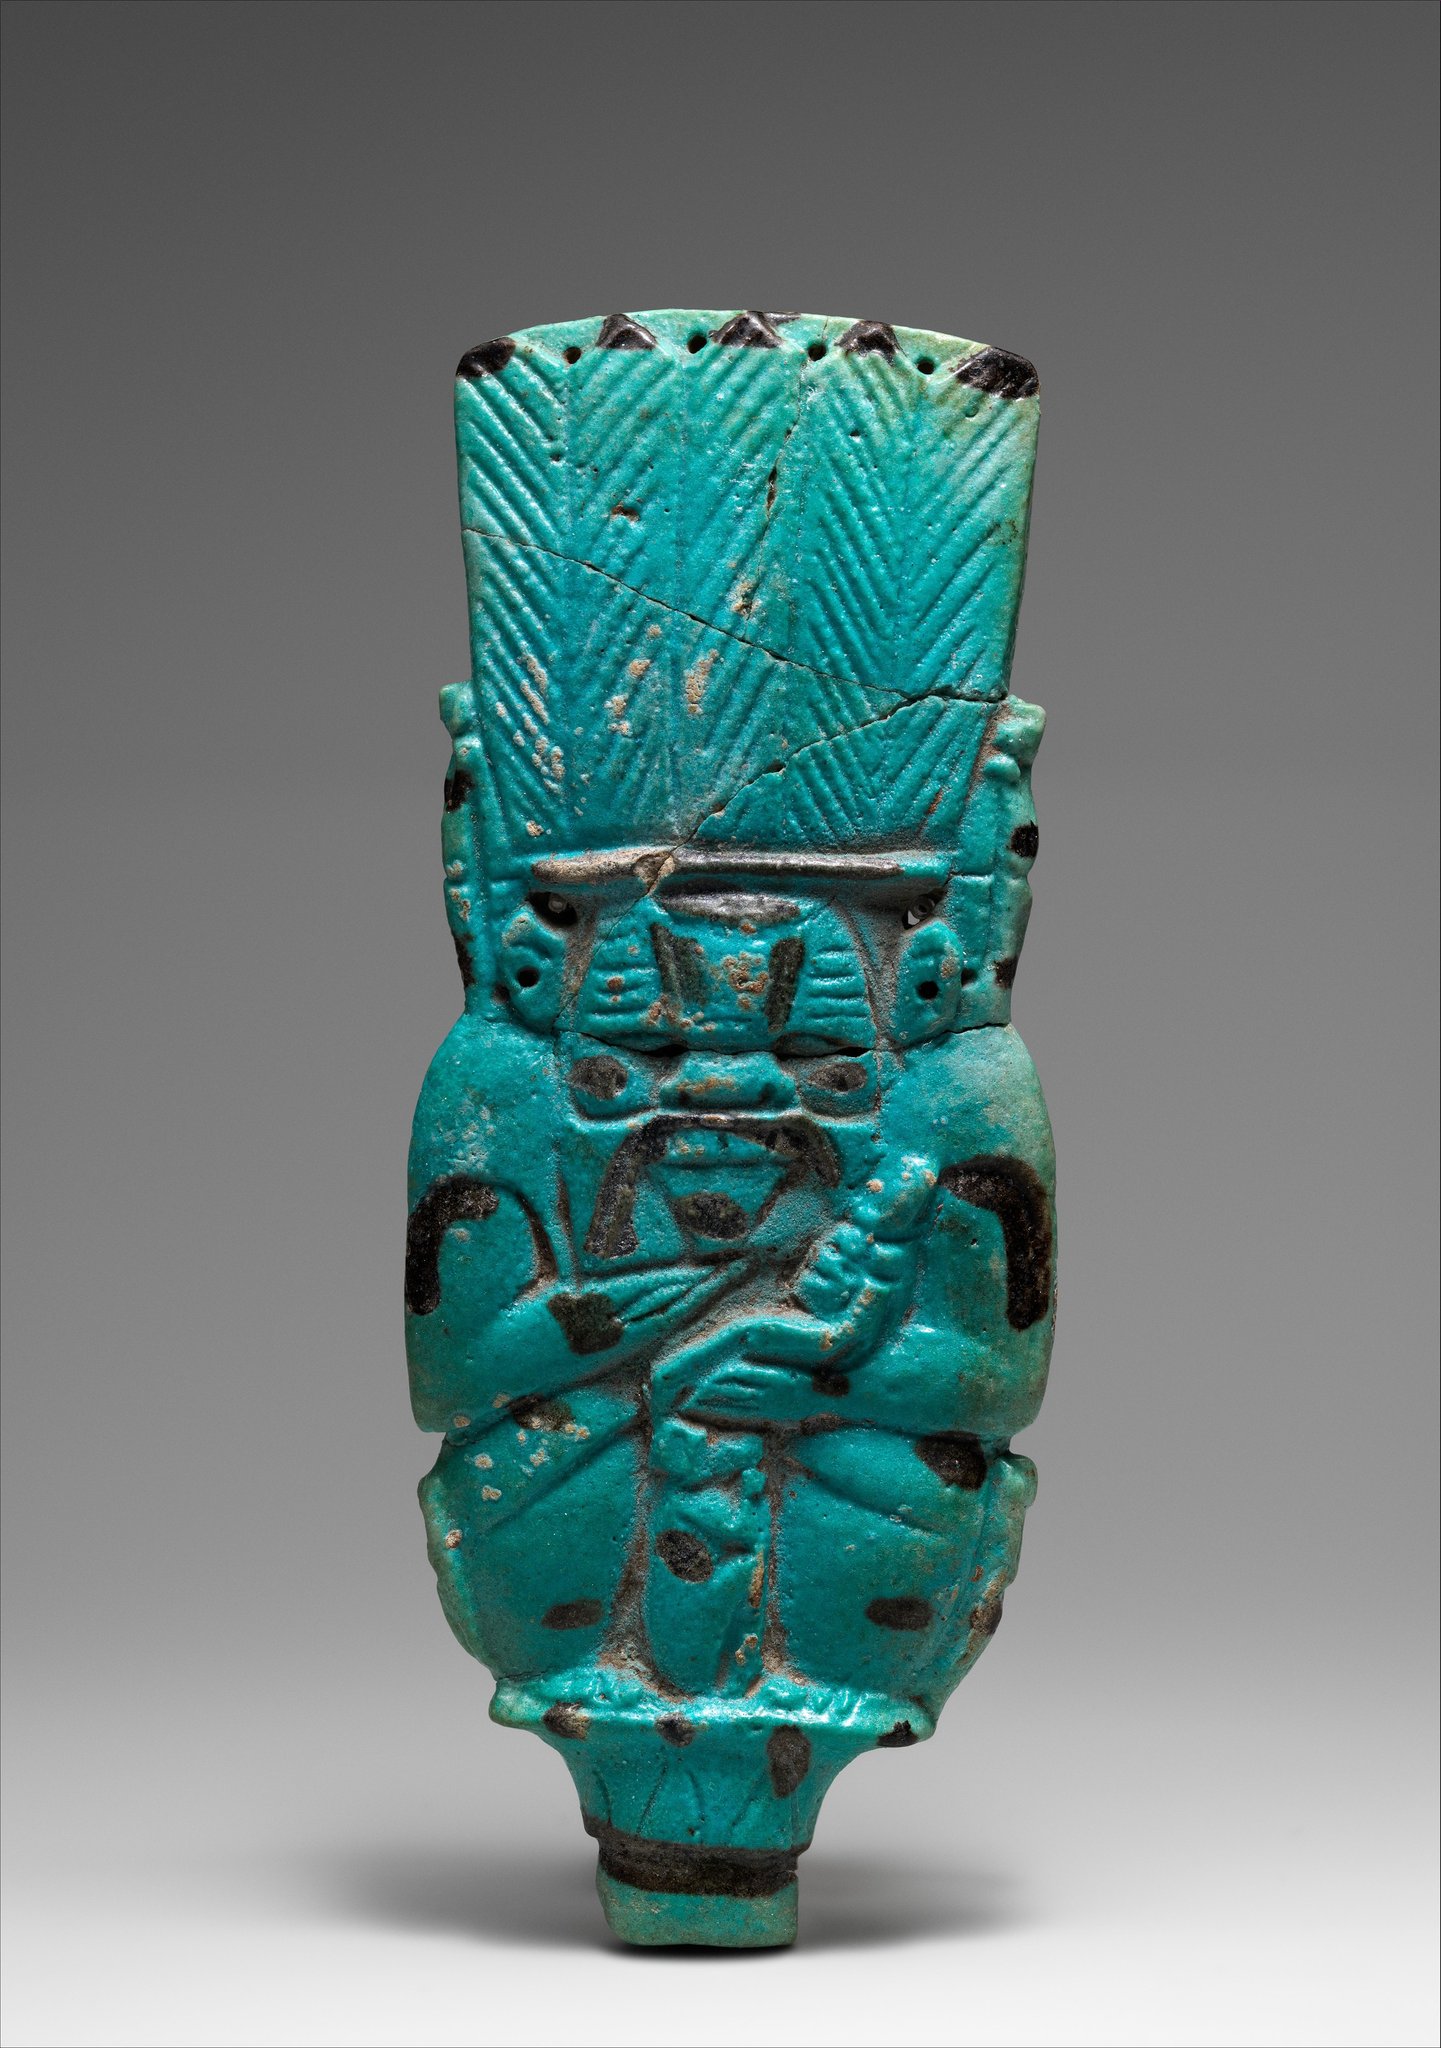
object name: be, rattle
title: Bes-image Rattle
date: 1070-664 BCE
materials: faience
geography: egypt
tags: bes